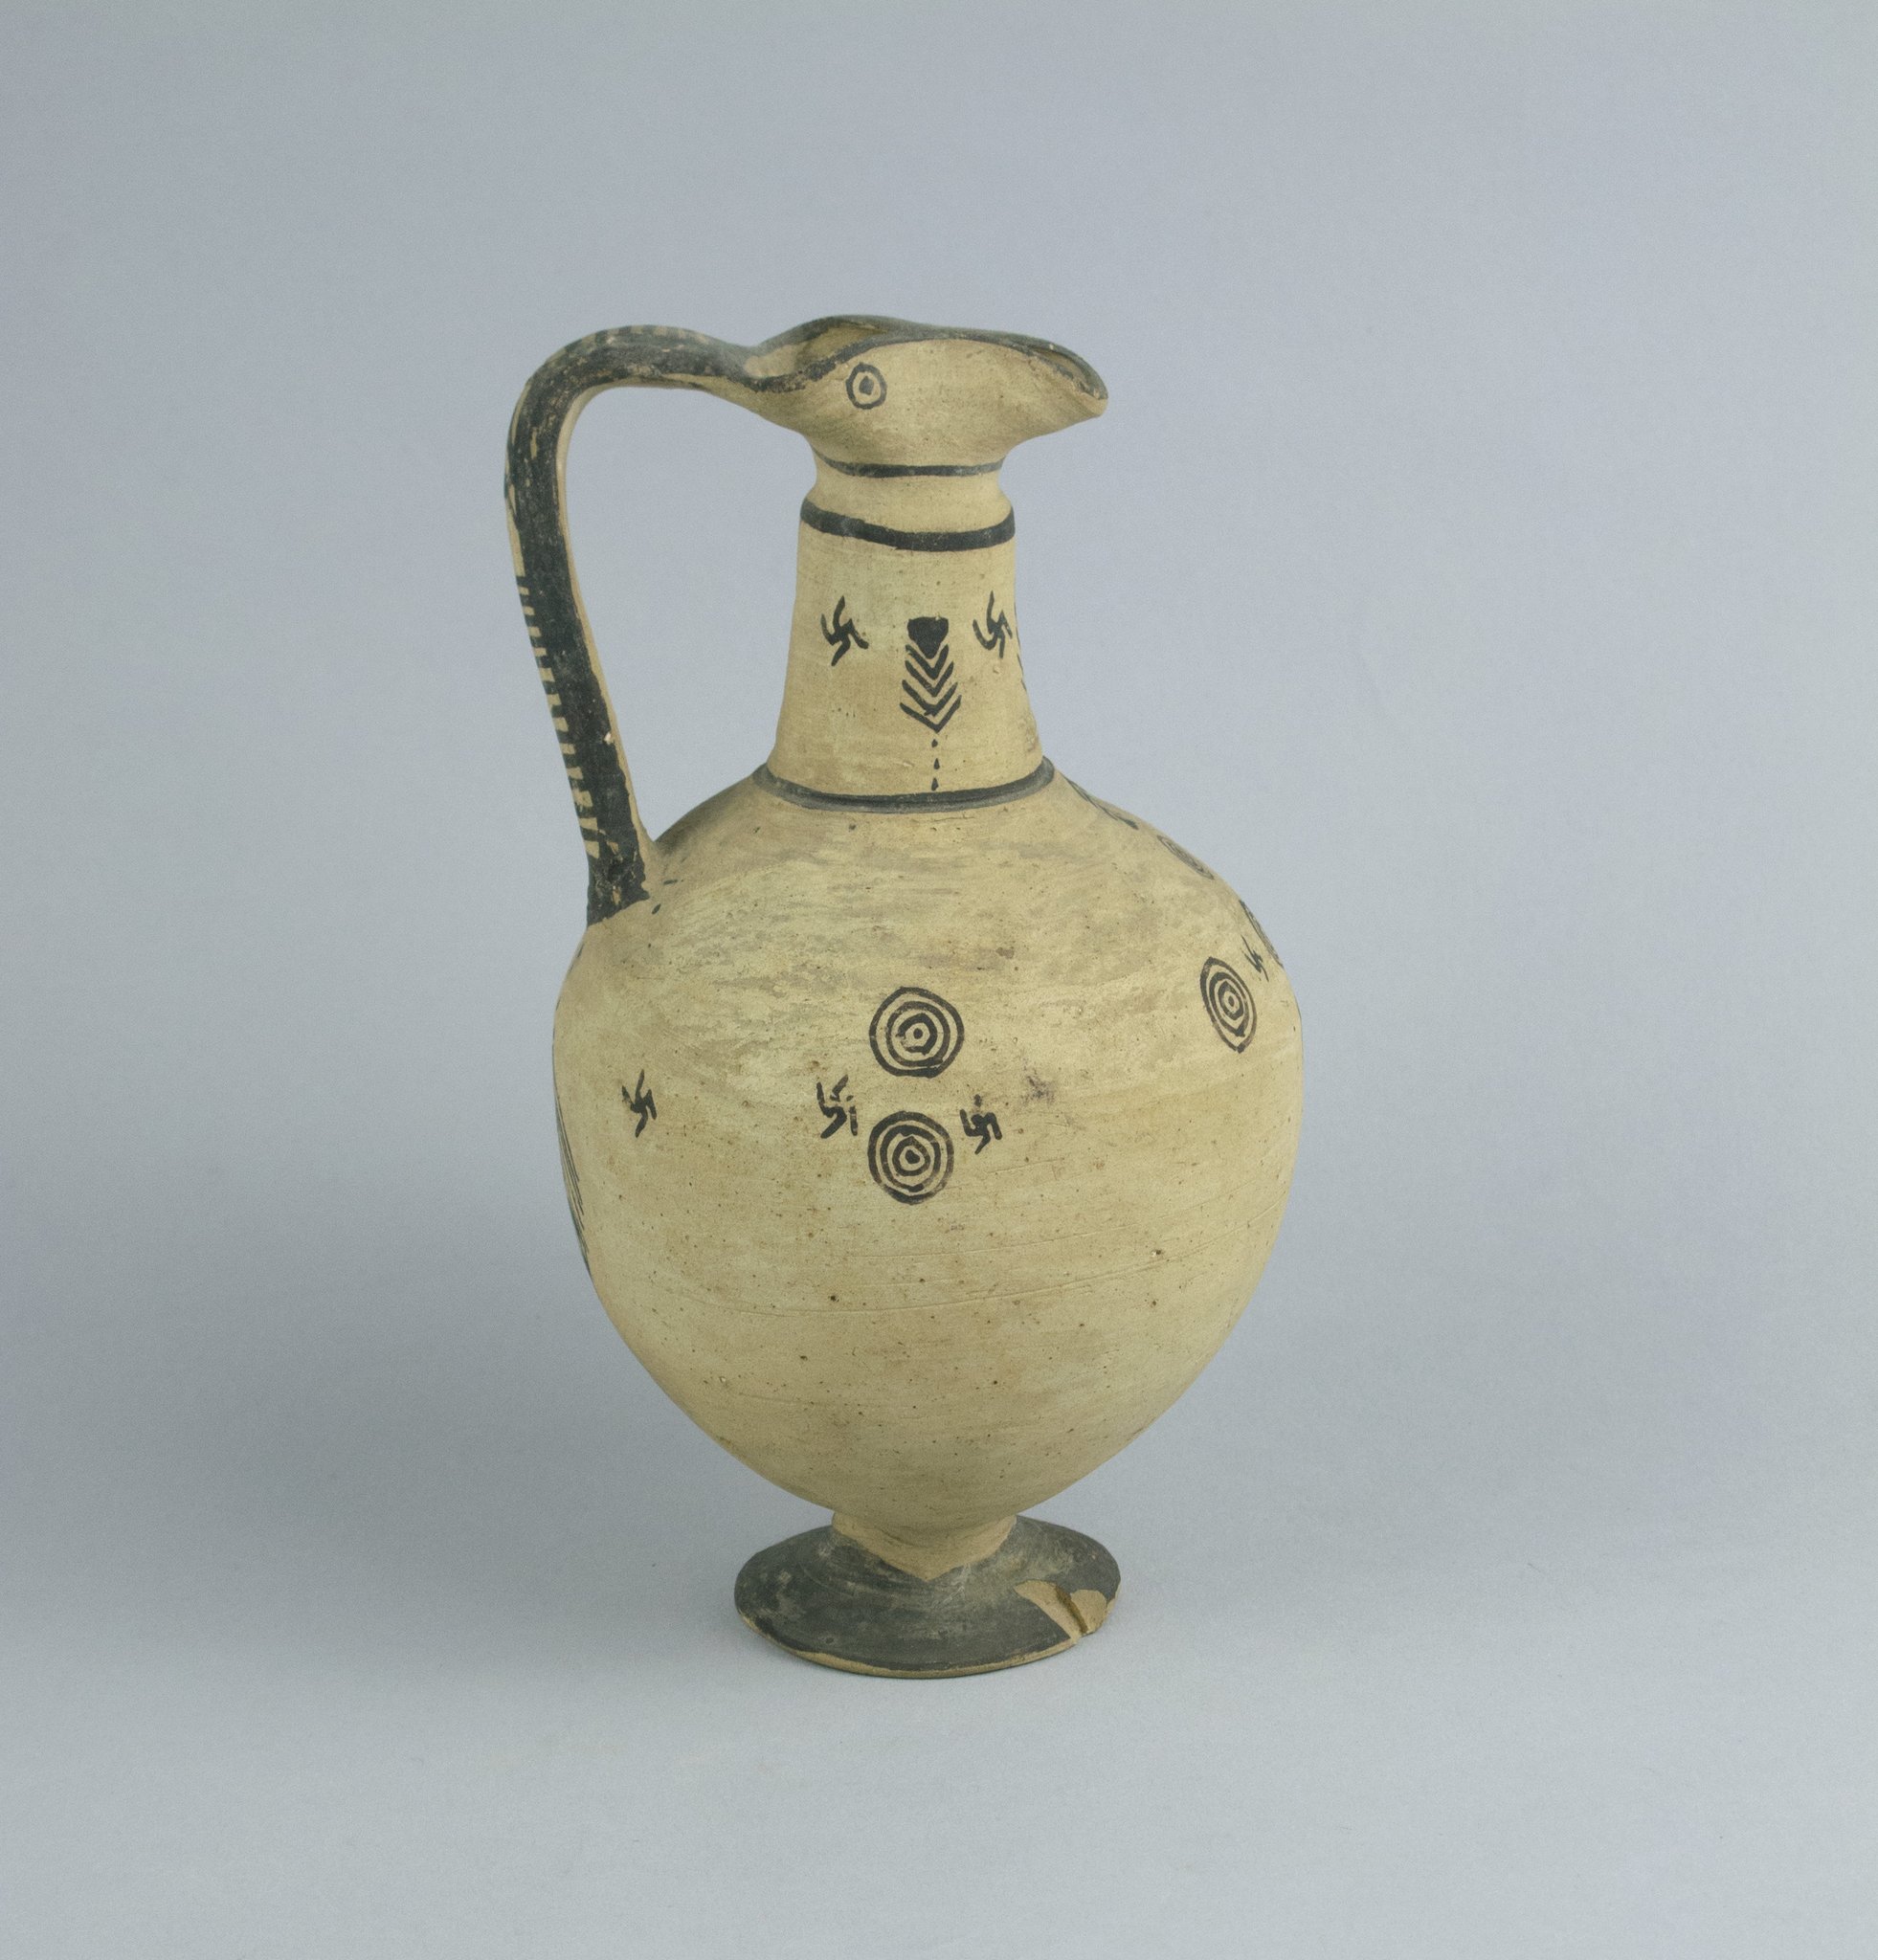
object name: jug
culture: cypriot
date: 750-600 BCE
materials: terracotta